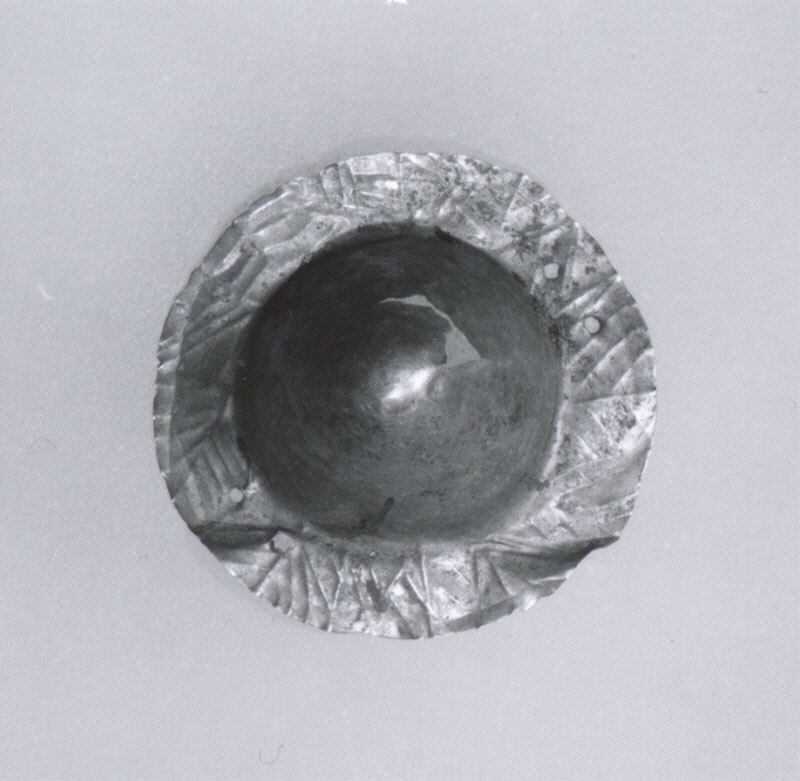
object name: bos or appliqué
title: Boss or appliqué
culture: iranian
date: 1-1000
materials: gold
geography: iran